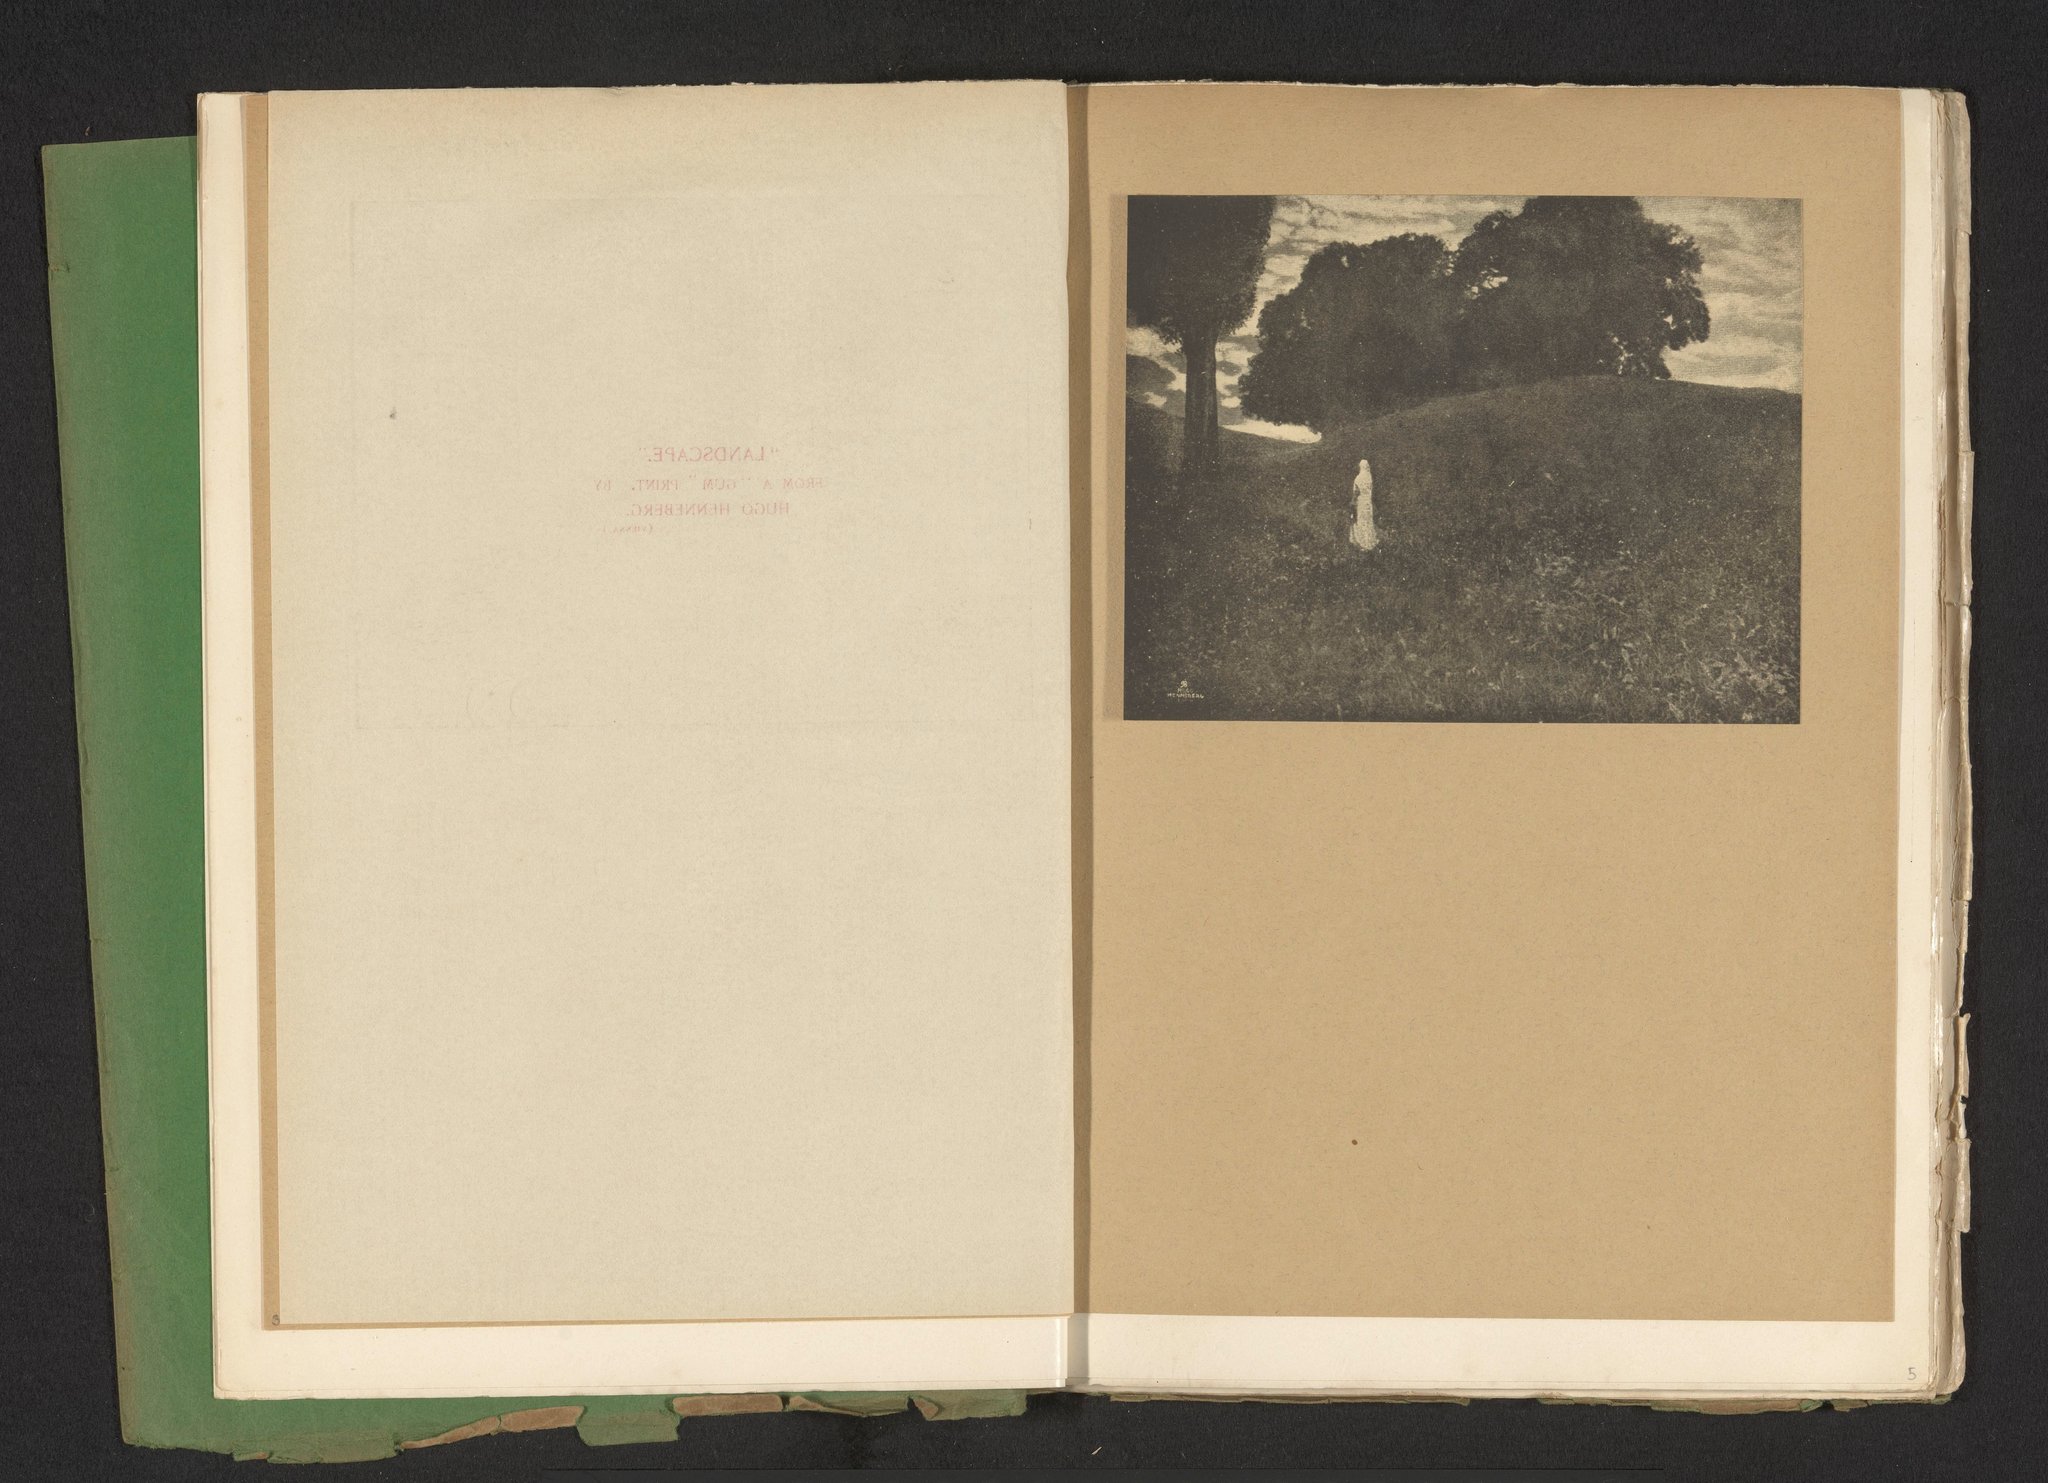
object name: page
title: Landschap met een vrouw en bomen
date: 1897-1902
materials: paper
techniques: autotype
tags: trees, adult woman, landscapes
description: Prent op derde ongenummerde pagina na pagina 238, achter semi-transparante omslag.